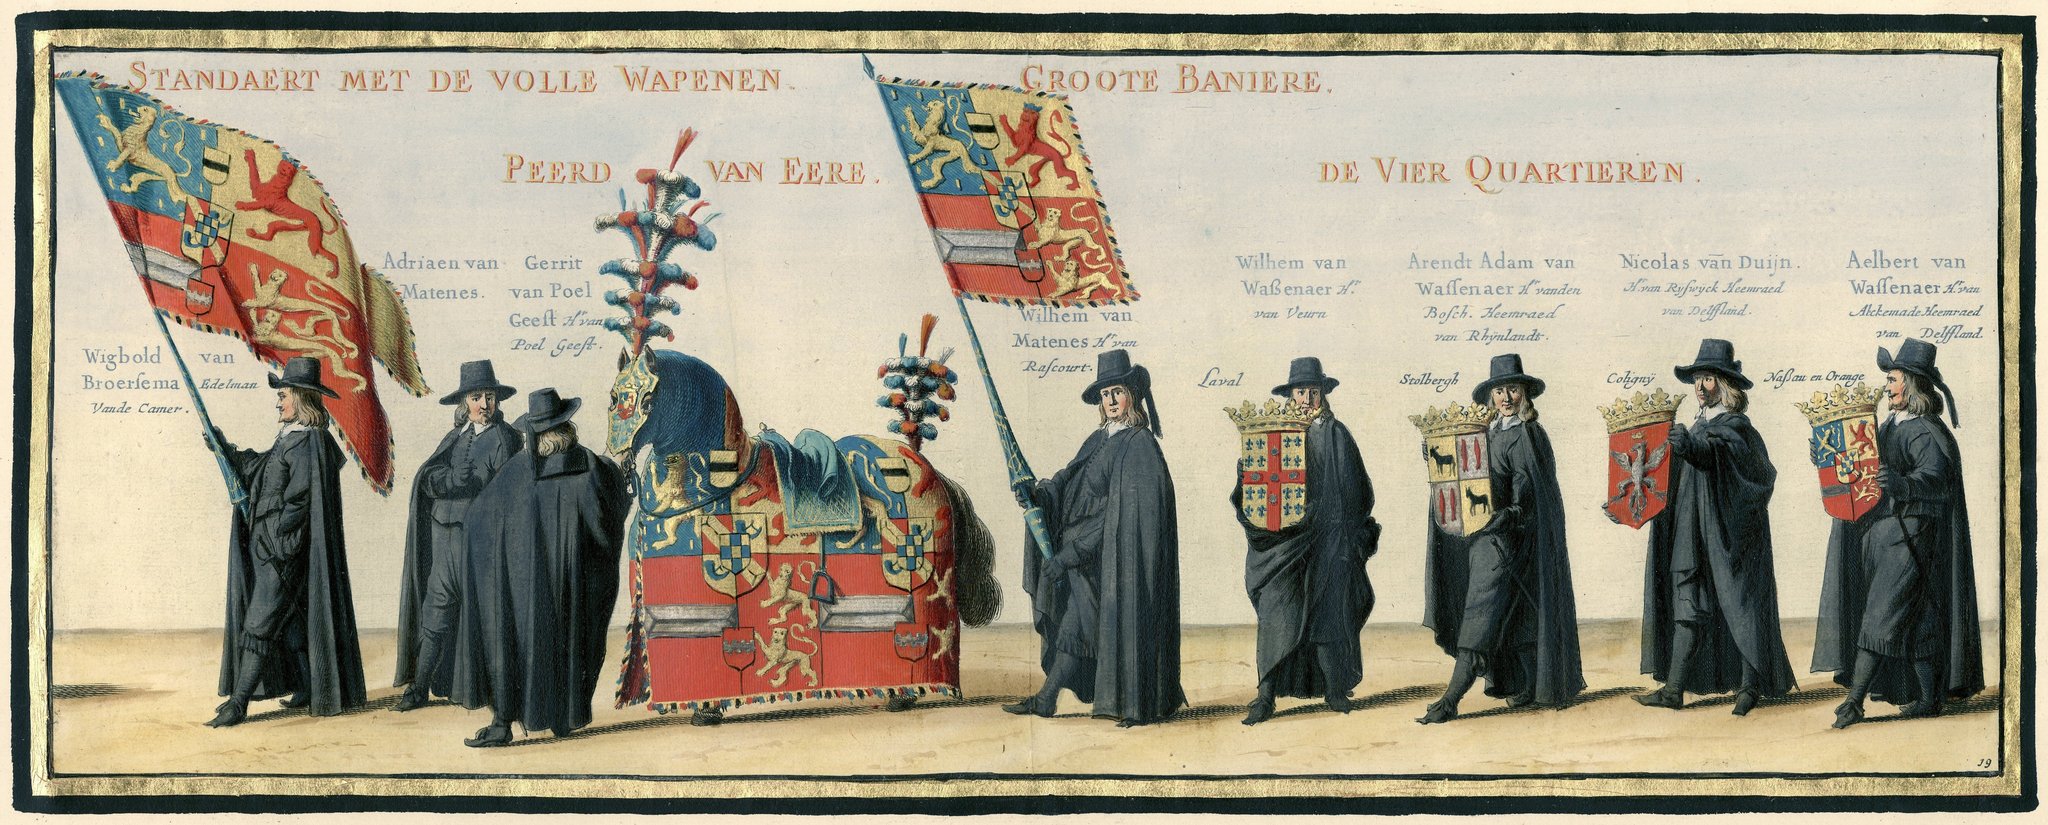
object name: book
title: Begraeffenisse van syne hoogheyt Frederick Henrick. Luxe ingekleurde uitgave van de prenten van de begrafenisstoet van Frederik Hendrik in 1647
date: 1651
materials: paint, paper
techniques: colour, etching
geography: the hague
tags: delft, the hague, frederick henry (prince of orange)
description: De begrafenisstoet van Frederik Hendrik, plaat nr. 19. Ingekleurde prent in een omlijsting versierd met goud en ingeplakt in de luxe editie uit ca. 1755 van het boek 'Begraeffenisse van syne hoogheyt Frederick Henrick' van Pieter Post, uitgegeven te Amsterdam in 1651.